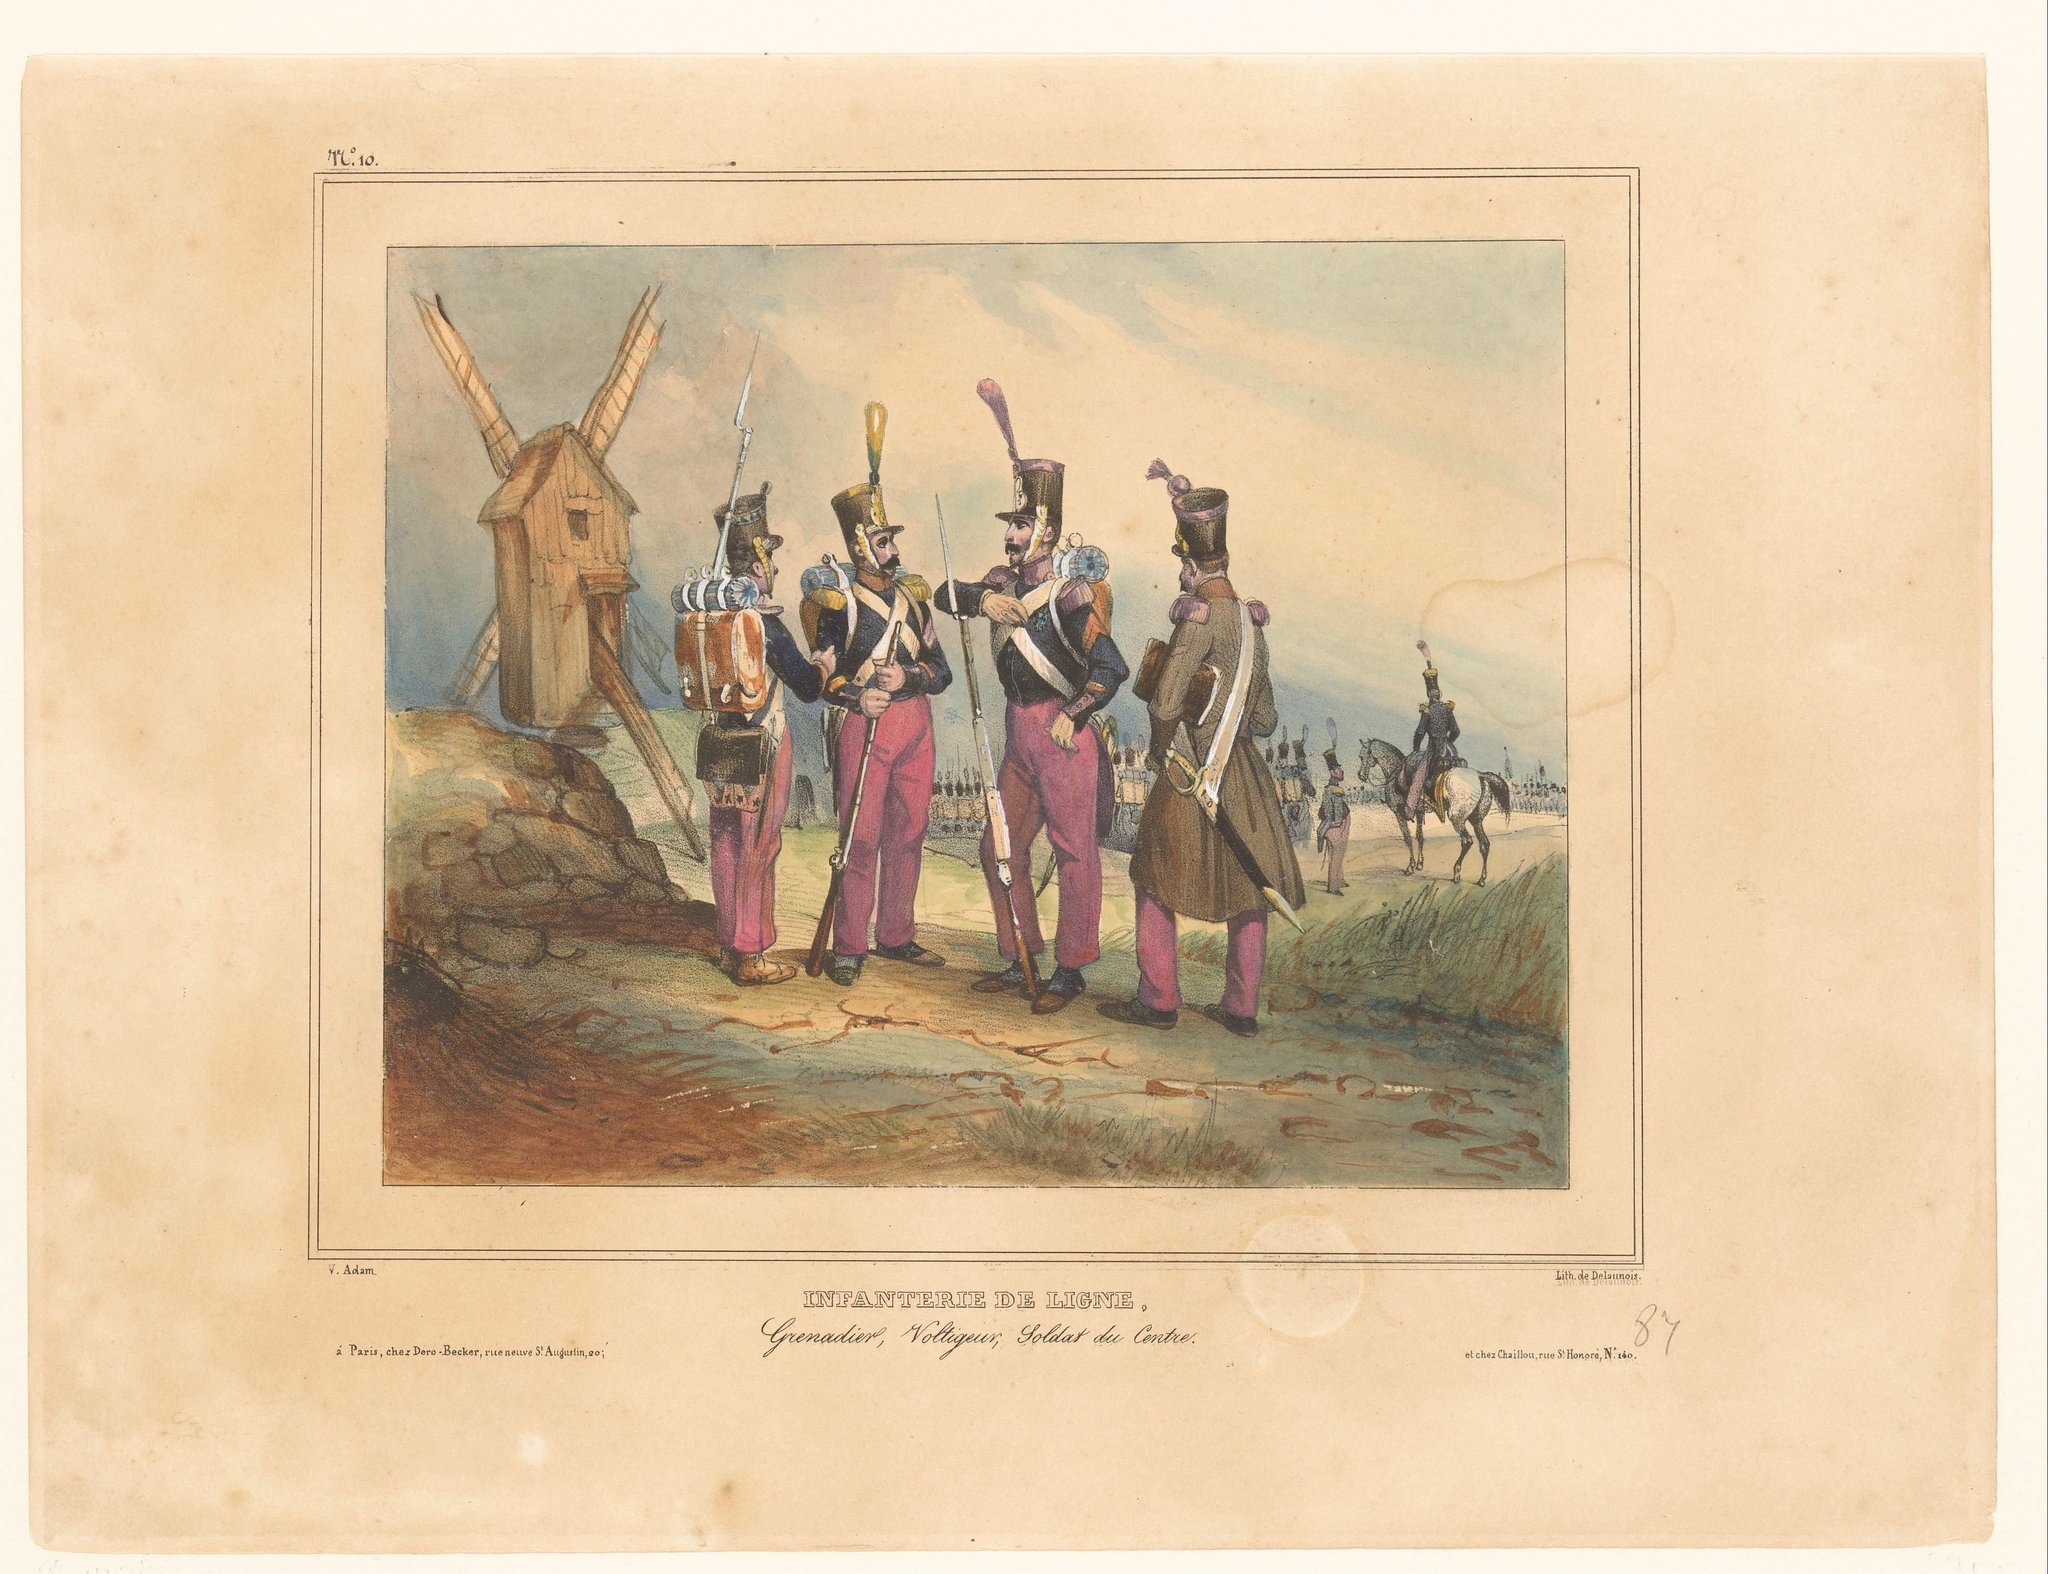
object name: print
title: Collection de costumes militaires, armée française 1832, représentés dans des sujets de genre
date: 1832-1833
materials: paper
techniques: hand coloring, lithograph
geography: paris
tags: ranks in the army, land forces, the soldier; the soldier's life (+ infantry)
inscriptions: annotation: ‘87’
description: Vier infanteriesoldaten van de linie maken een praatje. Ze hebben verschillende functies: grenadier, voltigeur, centrumsoldaat.